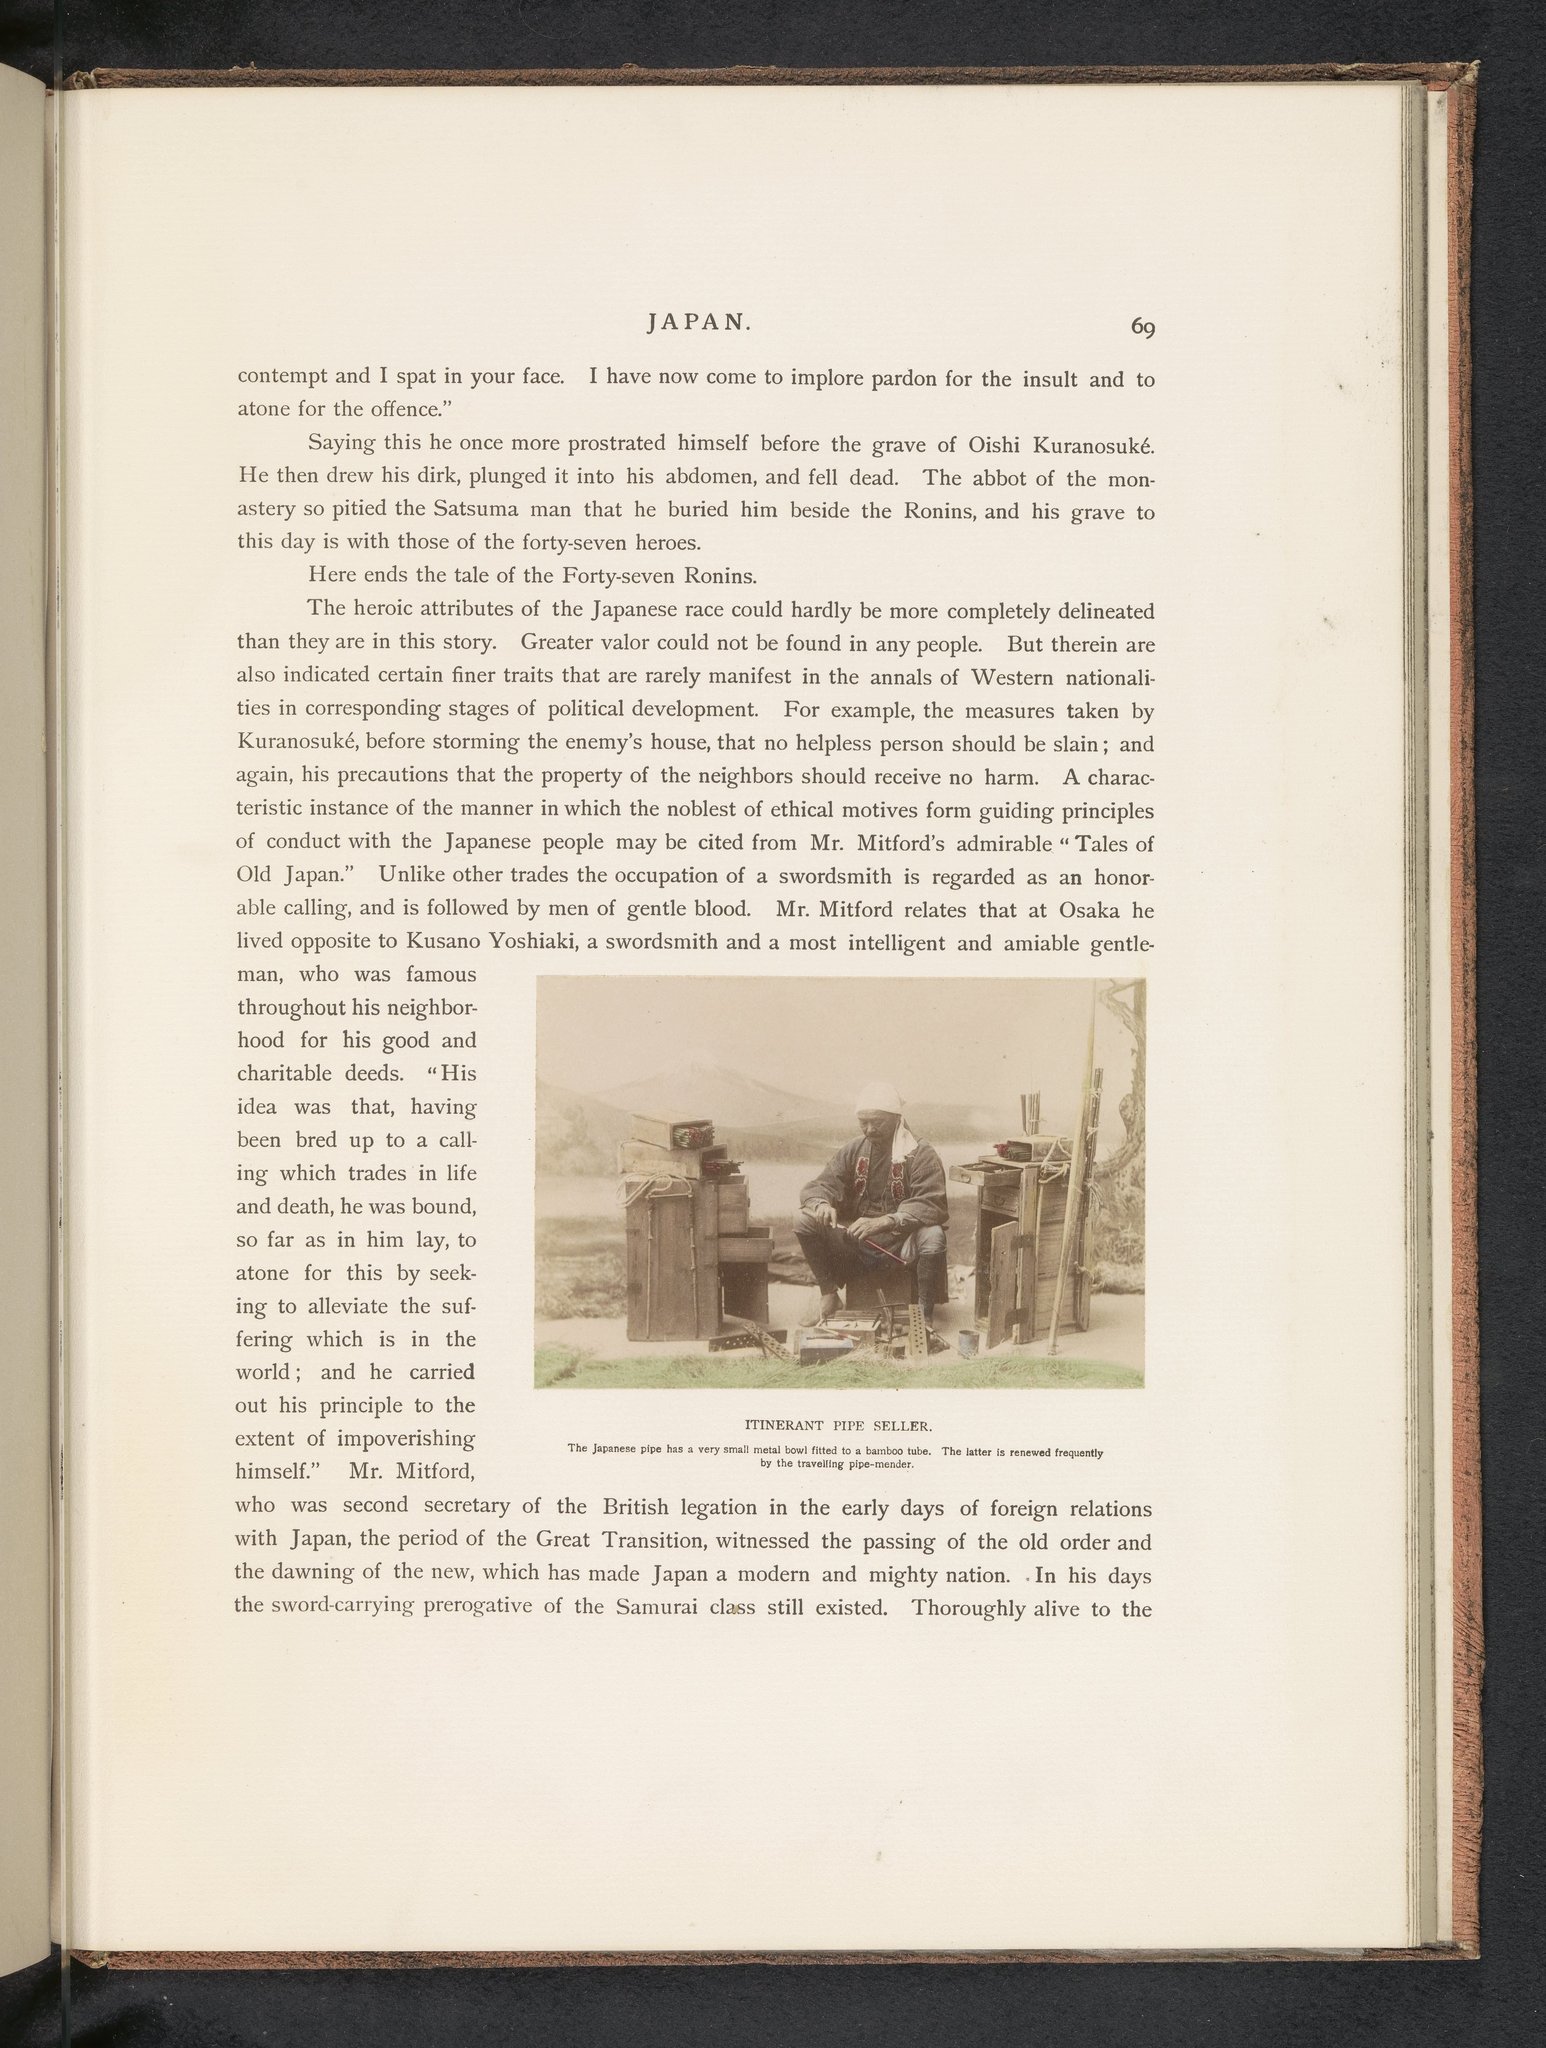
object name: page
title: Itinerant pipe seller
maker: Anonymous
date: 1887-1897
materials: photographic support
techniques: albumen print, hand coloring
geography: japan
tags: pipe ~ tobacco, merchant, salesman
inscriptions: inscription: ‘The Japanese pipe has a very small metal bowl fitted to a bamboo tube. The latter is renewed frequently by the travelling pipe-mender.’